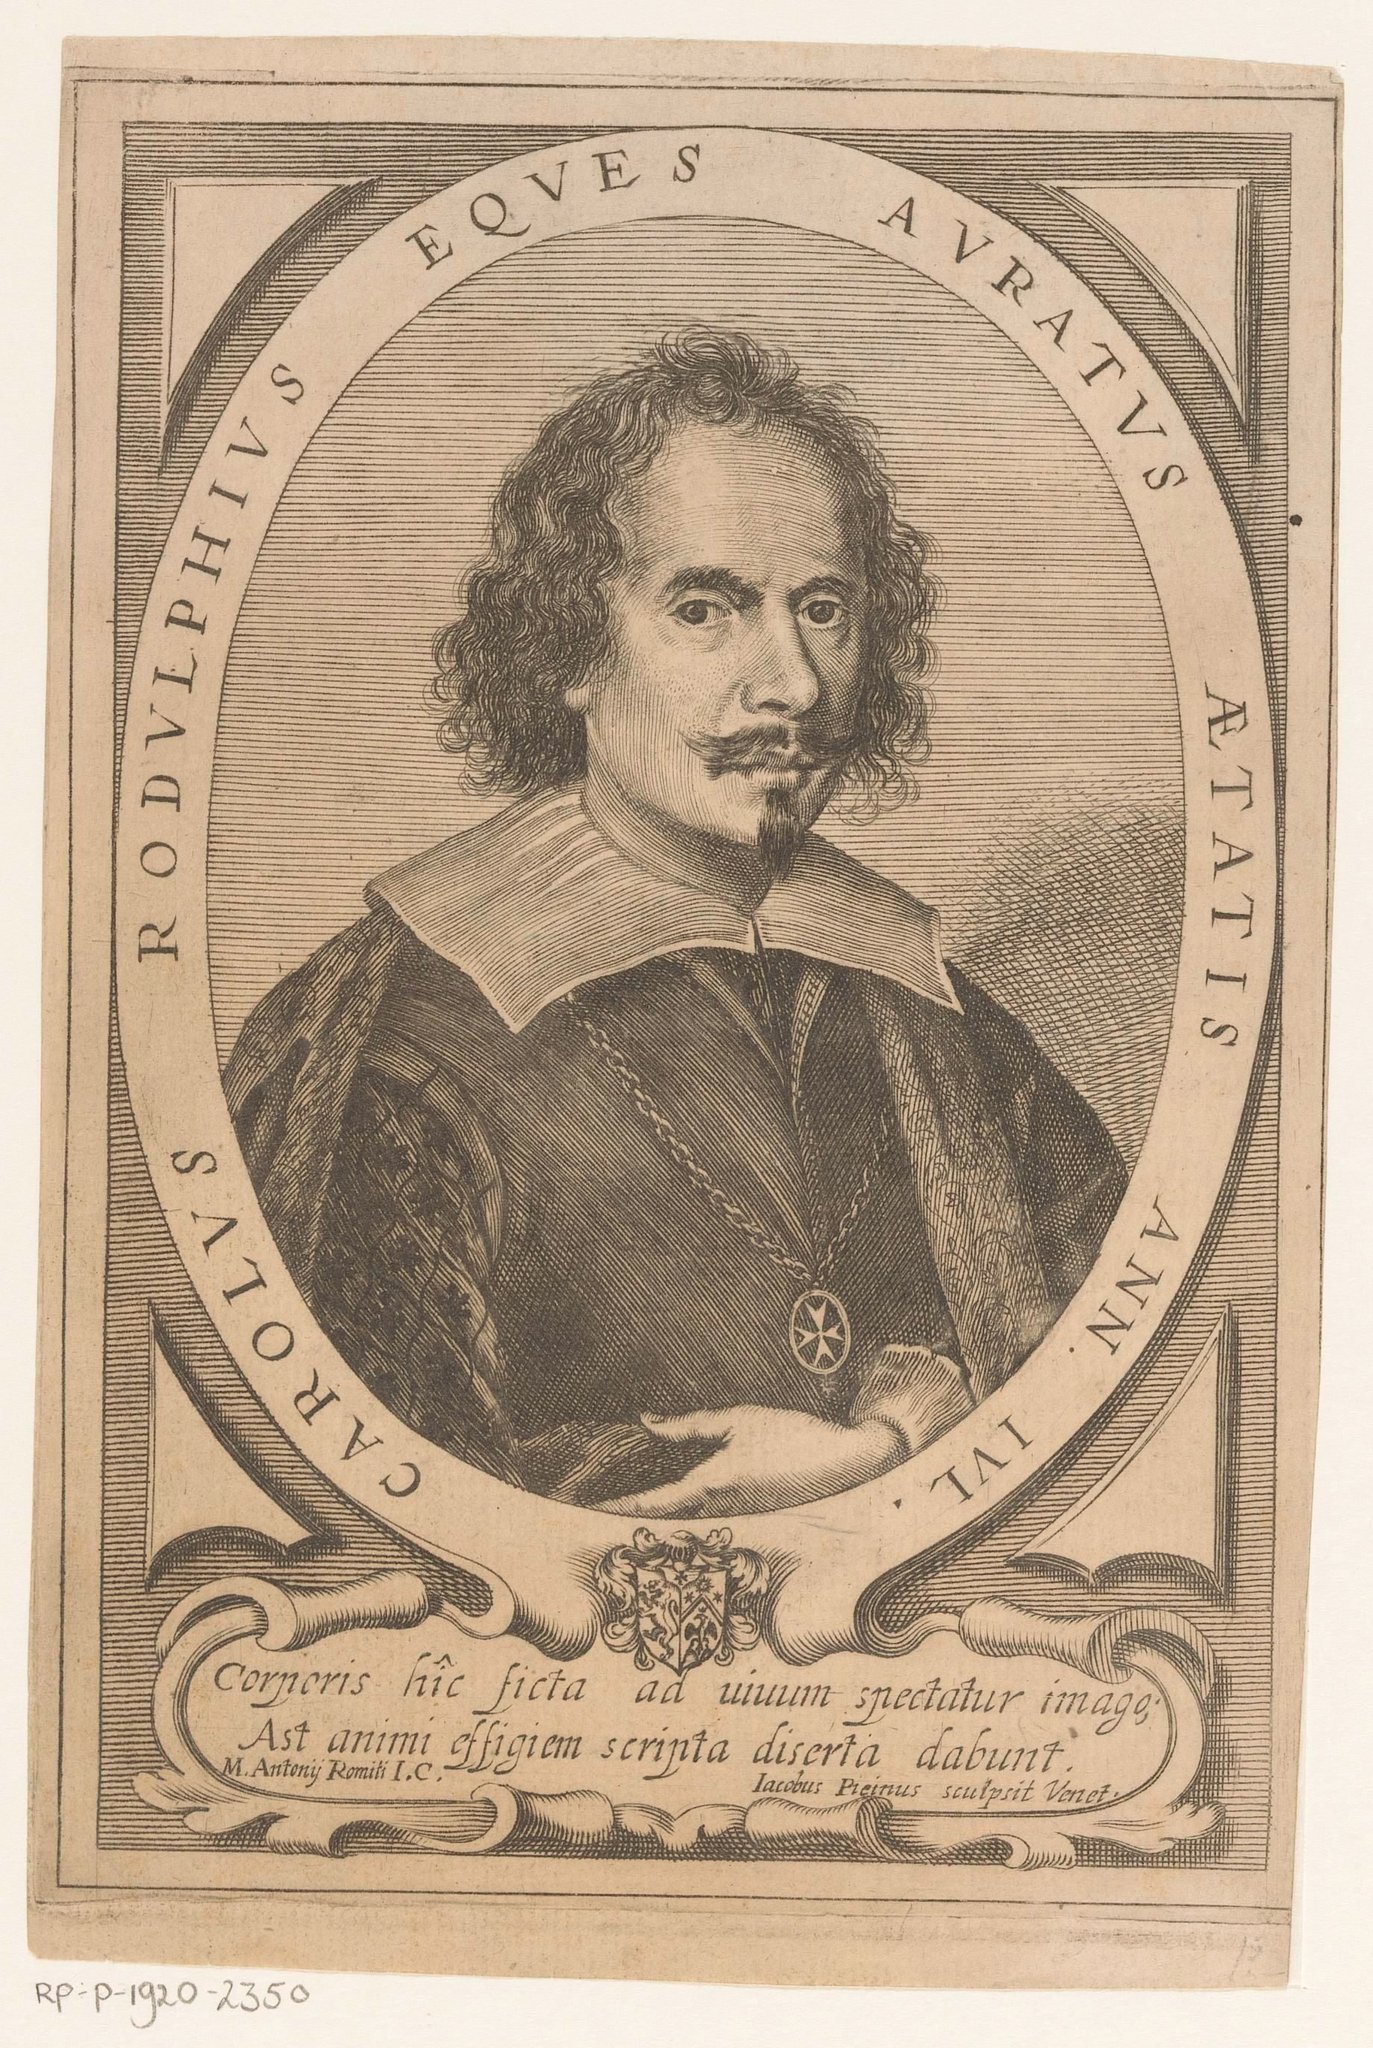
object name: book illustration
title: Portret van schilder en schrijver Carlo Ridolfi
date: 1648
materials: paper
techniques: engraving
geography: italy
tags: venice, painter, historical persons, portrait of a writer, portrait, self-portrait of artist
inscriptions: collector's mark: Lugt 2228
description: Prent gebruikt voor de publicatie: Ridolfi, Carlo. Le Maraviglie dell'Arte. Venetië: Giovanni Battista Sgava, 1648.